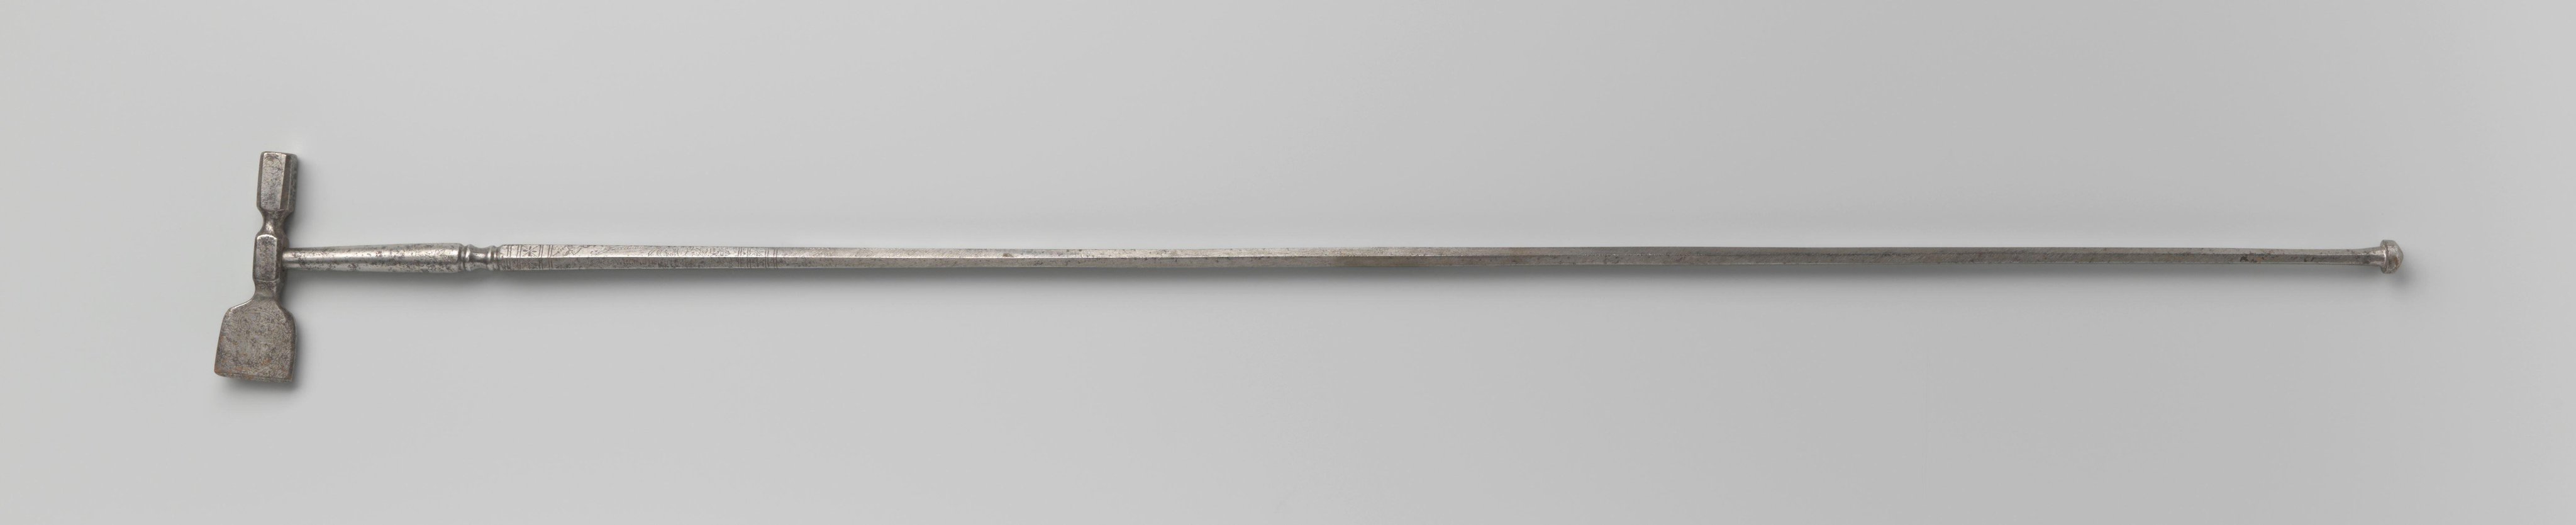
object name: hammer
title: Jachthamer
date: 1700-1800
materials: iron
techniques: engraving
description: Een ijzeren jachthamer. De zeskantige steel is door een baluster verbonden aan het conische bovendeel, dat de kop draagt. Deze is met graveerwerk versierd evenals het bovendeel van de steel. Op de klauw van de kop een omlijsting van bladwerk, waarin op één zijde, een hert. Op de steel spiralen geometrische- en bladornamenten.